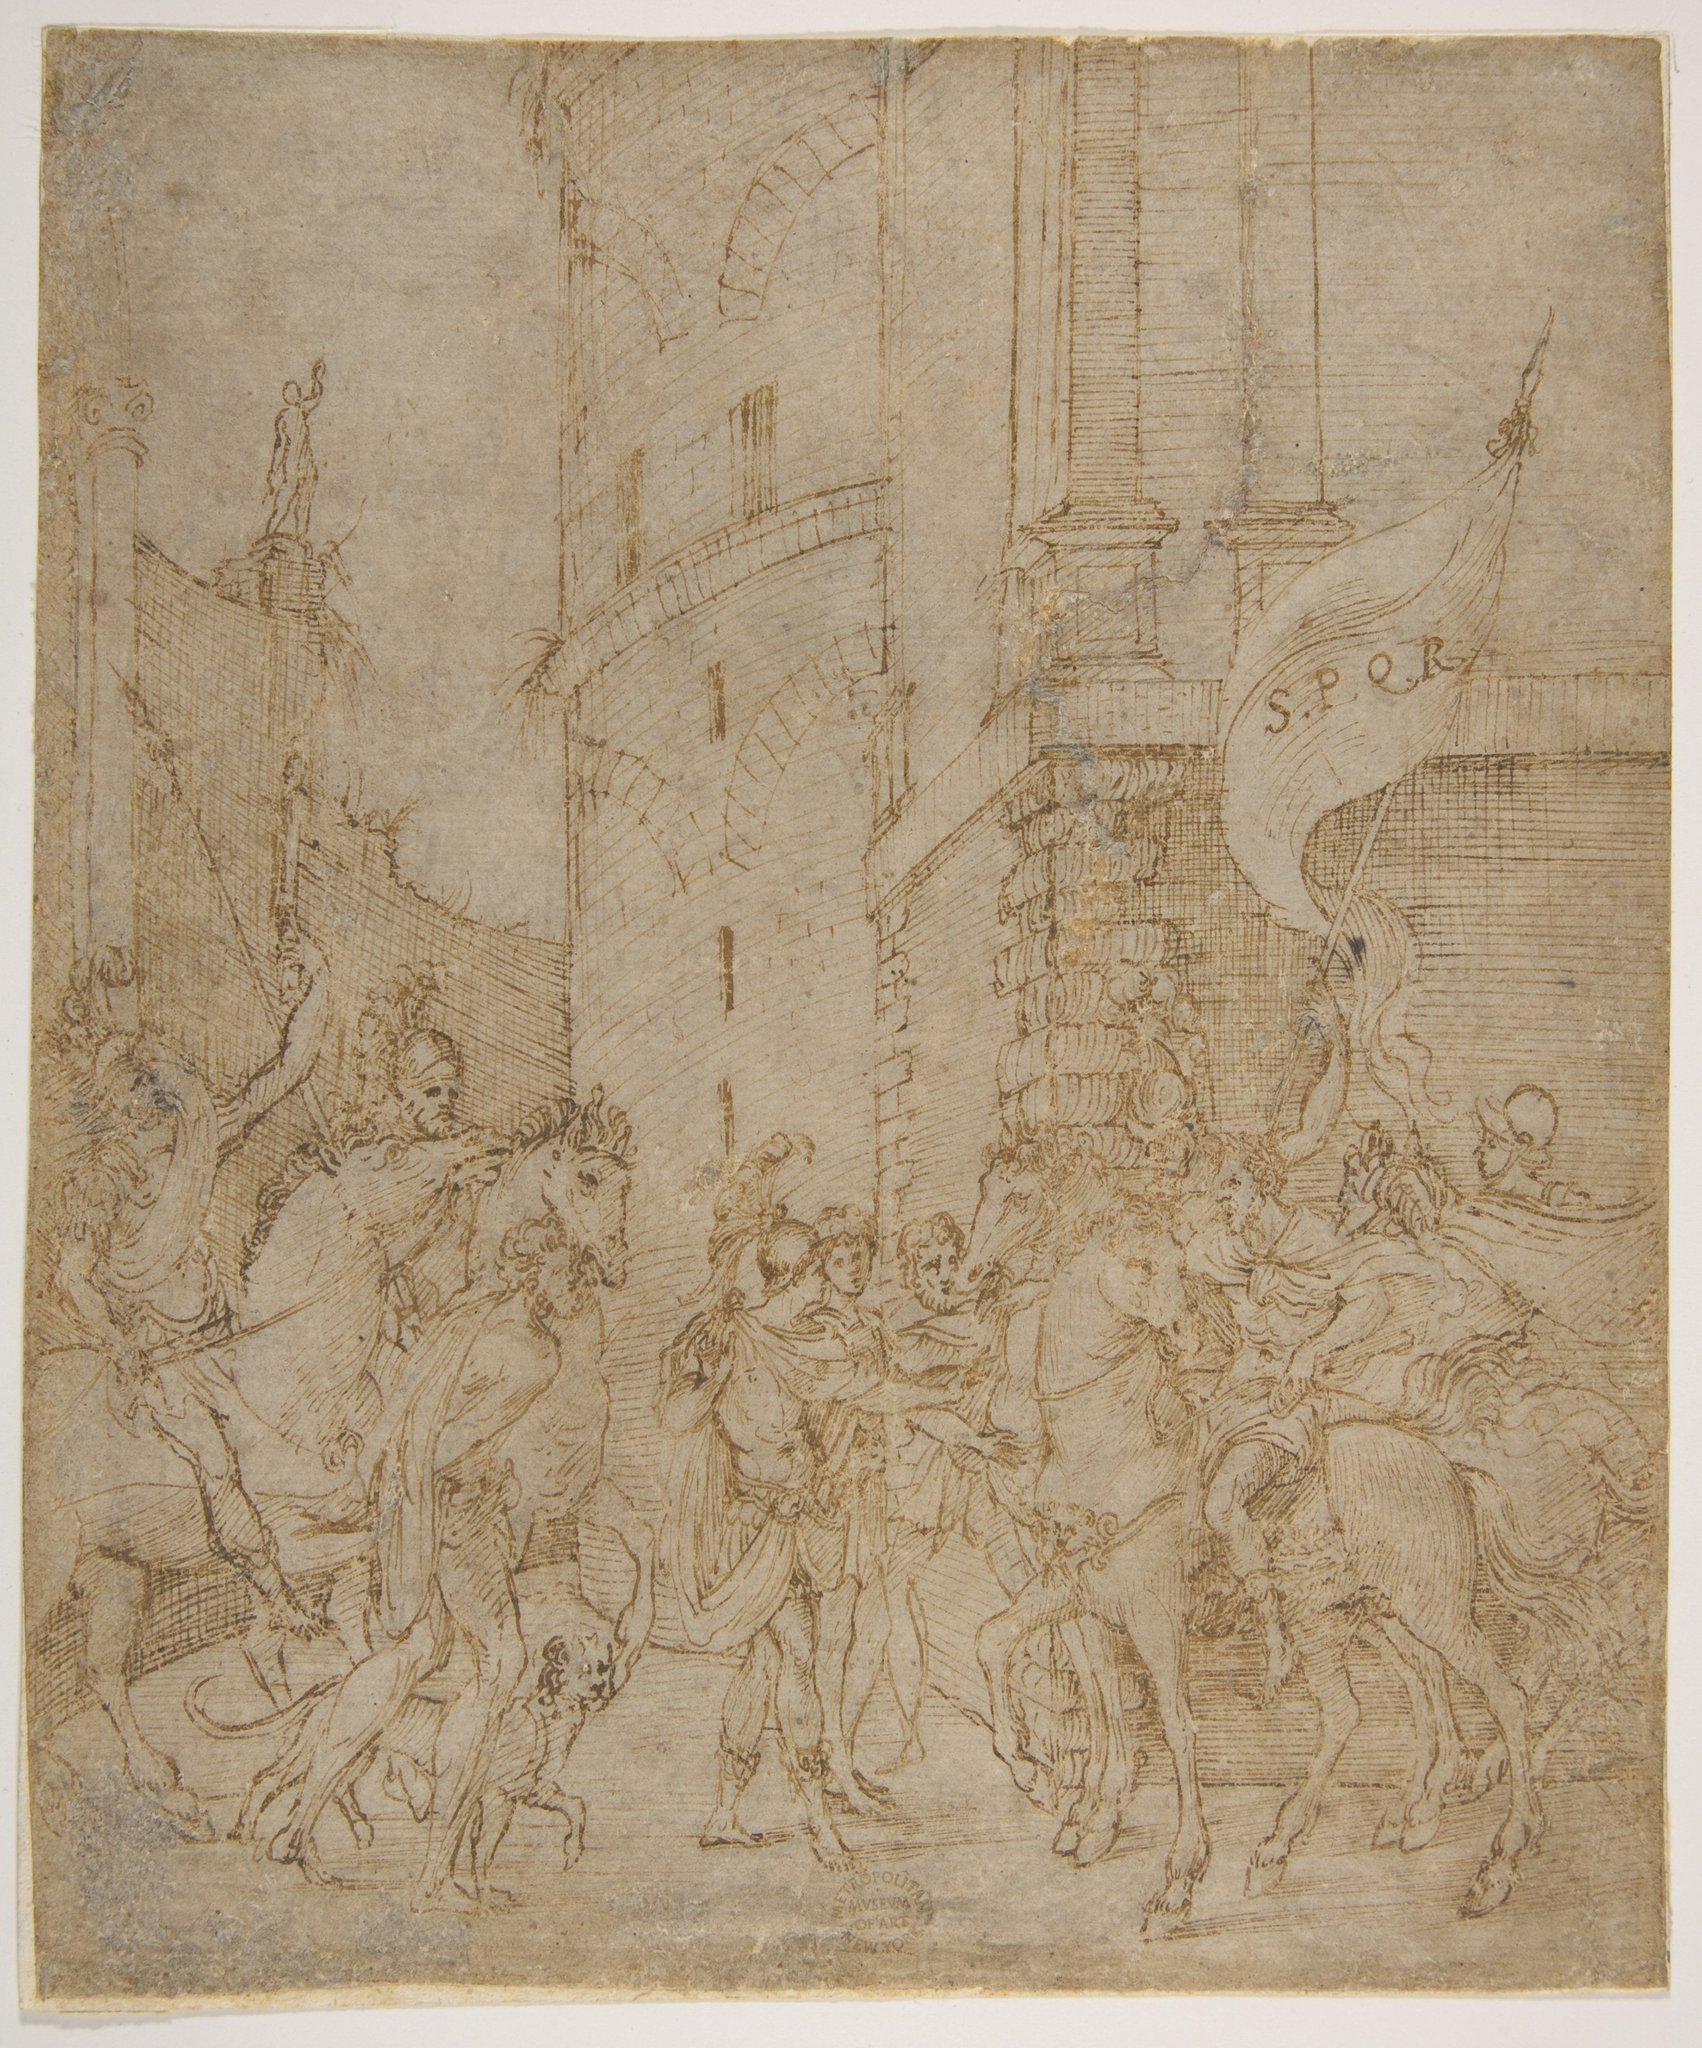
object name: drawing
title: Emperor greeted by a warrior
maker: marcantonio raimondi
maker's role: artist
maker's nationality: italian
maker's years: 1475-1534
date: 1501-1600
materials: ink, paper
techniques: pen, wash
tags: animals,soldiers,kings,horses